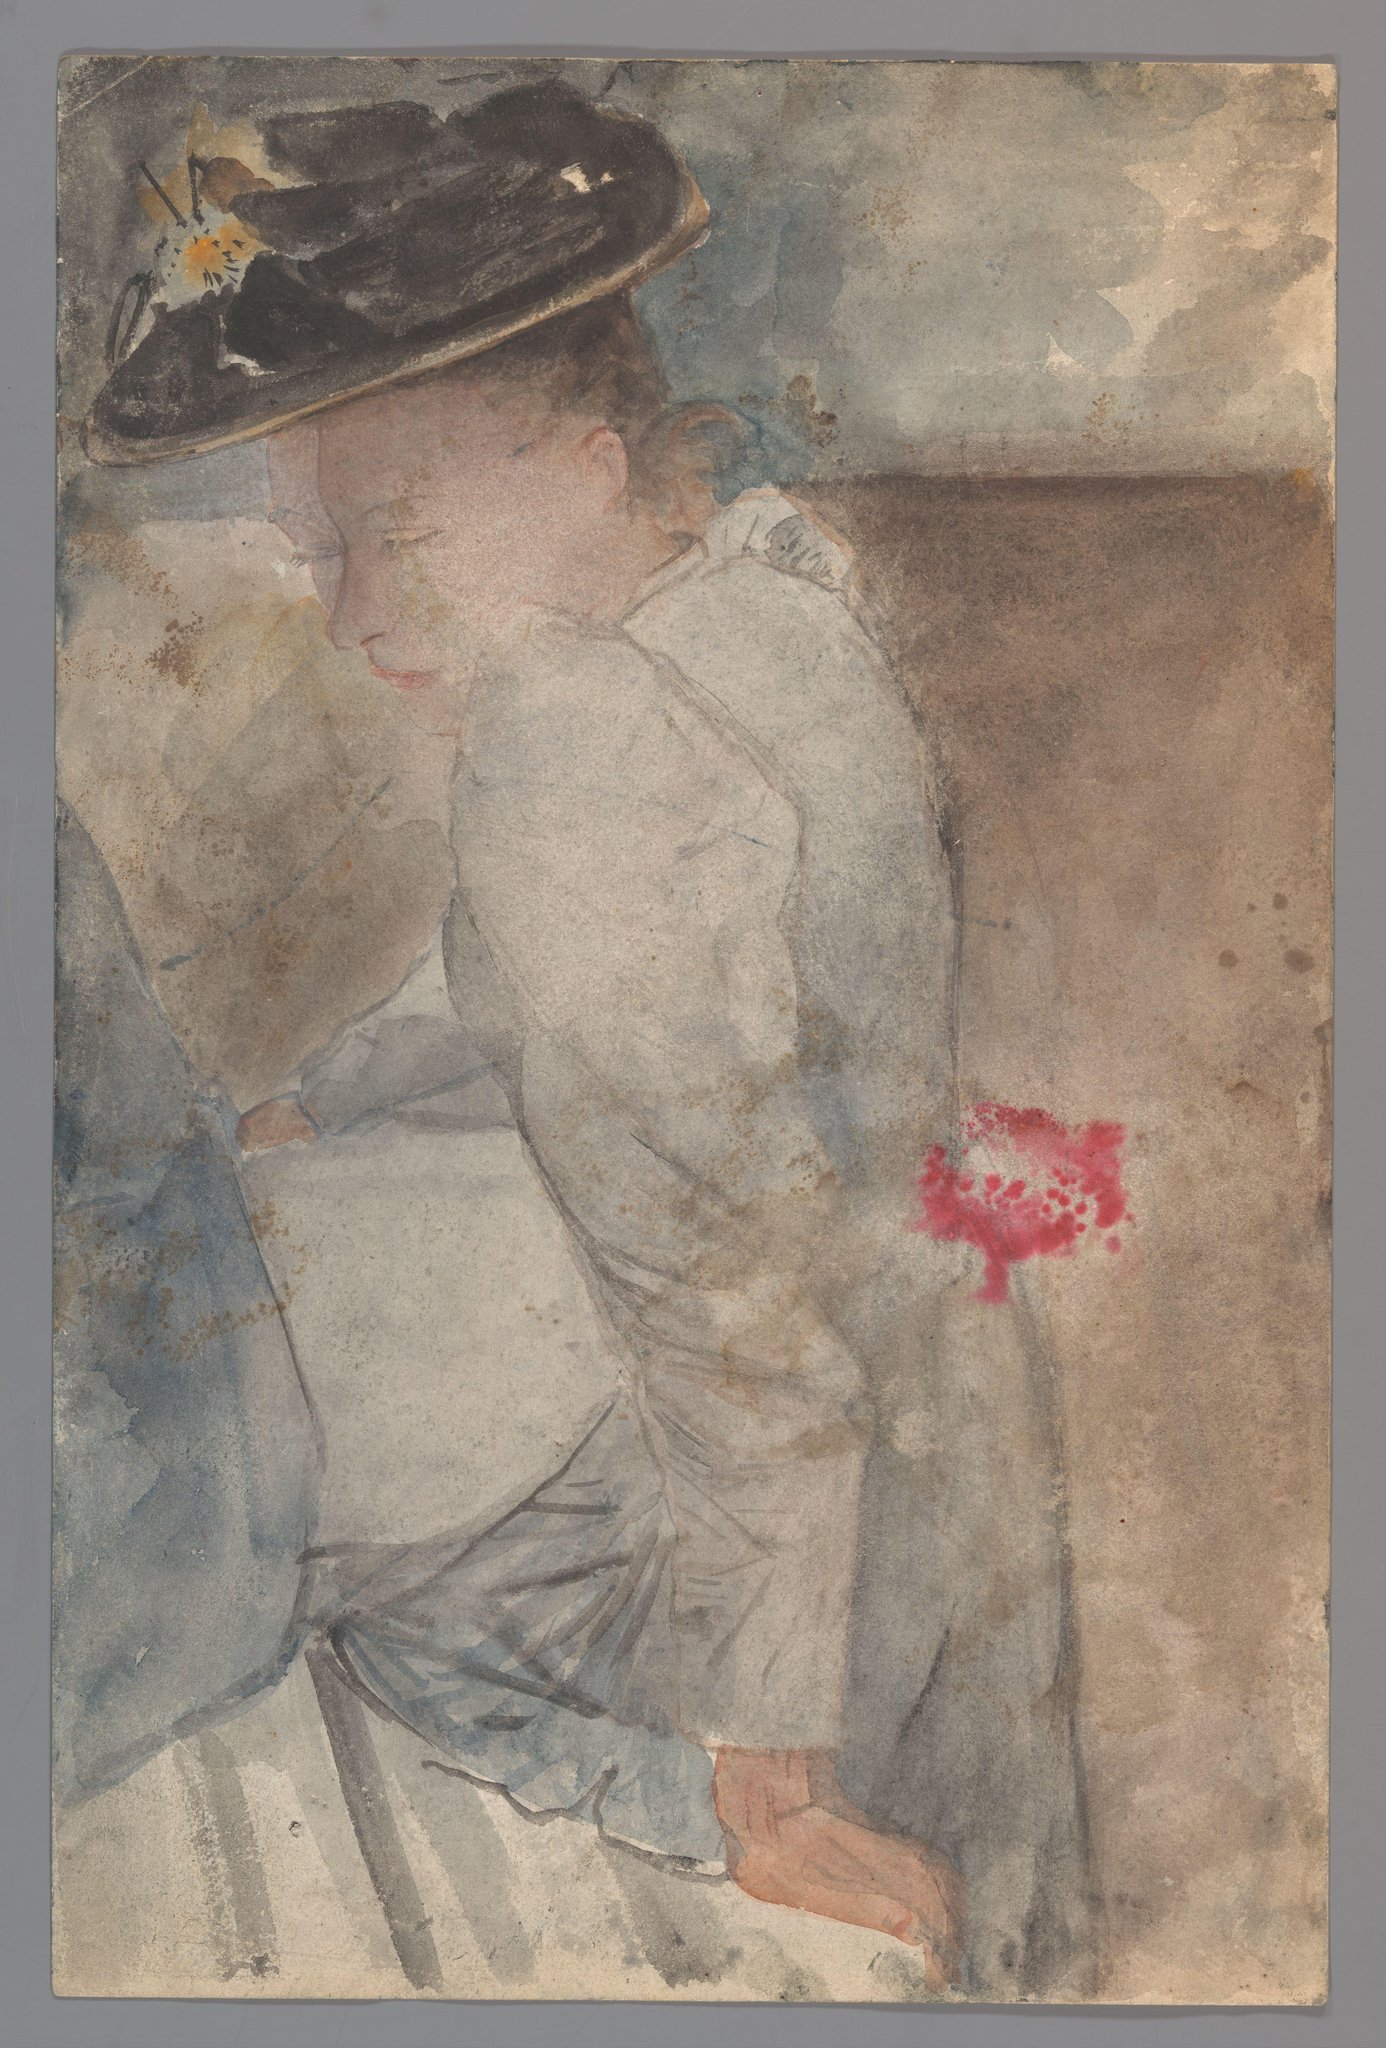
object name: watercolor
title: Zittende vrouw met platte hoed, steunend op haar linkerhand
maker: carel adolph lion cachet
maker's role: draughtsman, print maker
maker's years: 1864-1945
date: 1874-1945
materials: paper, watercolor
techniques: brush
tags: anonymous historical person portrayed alone